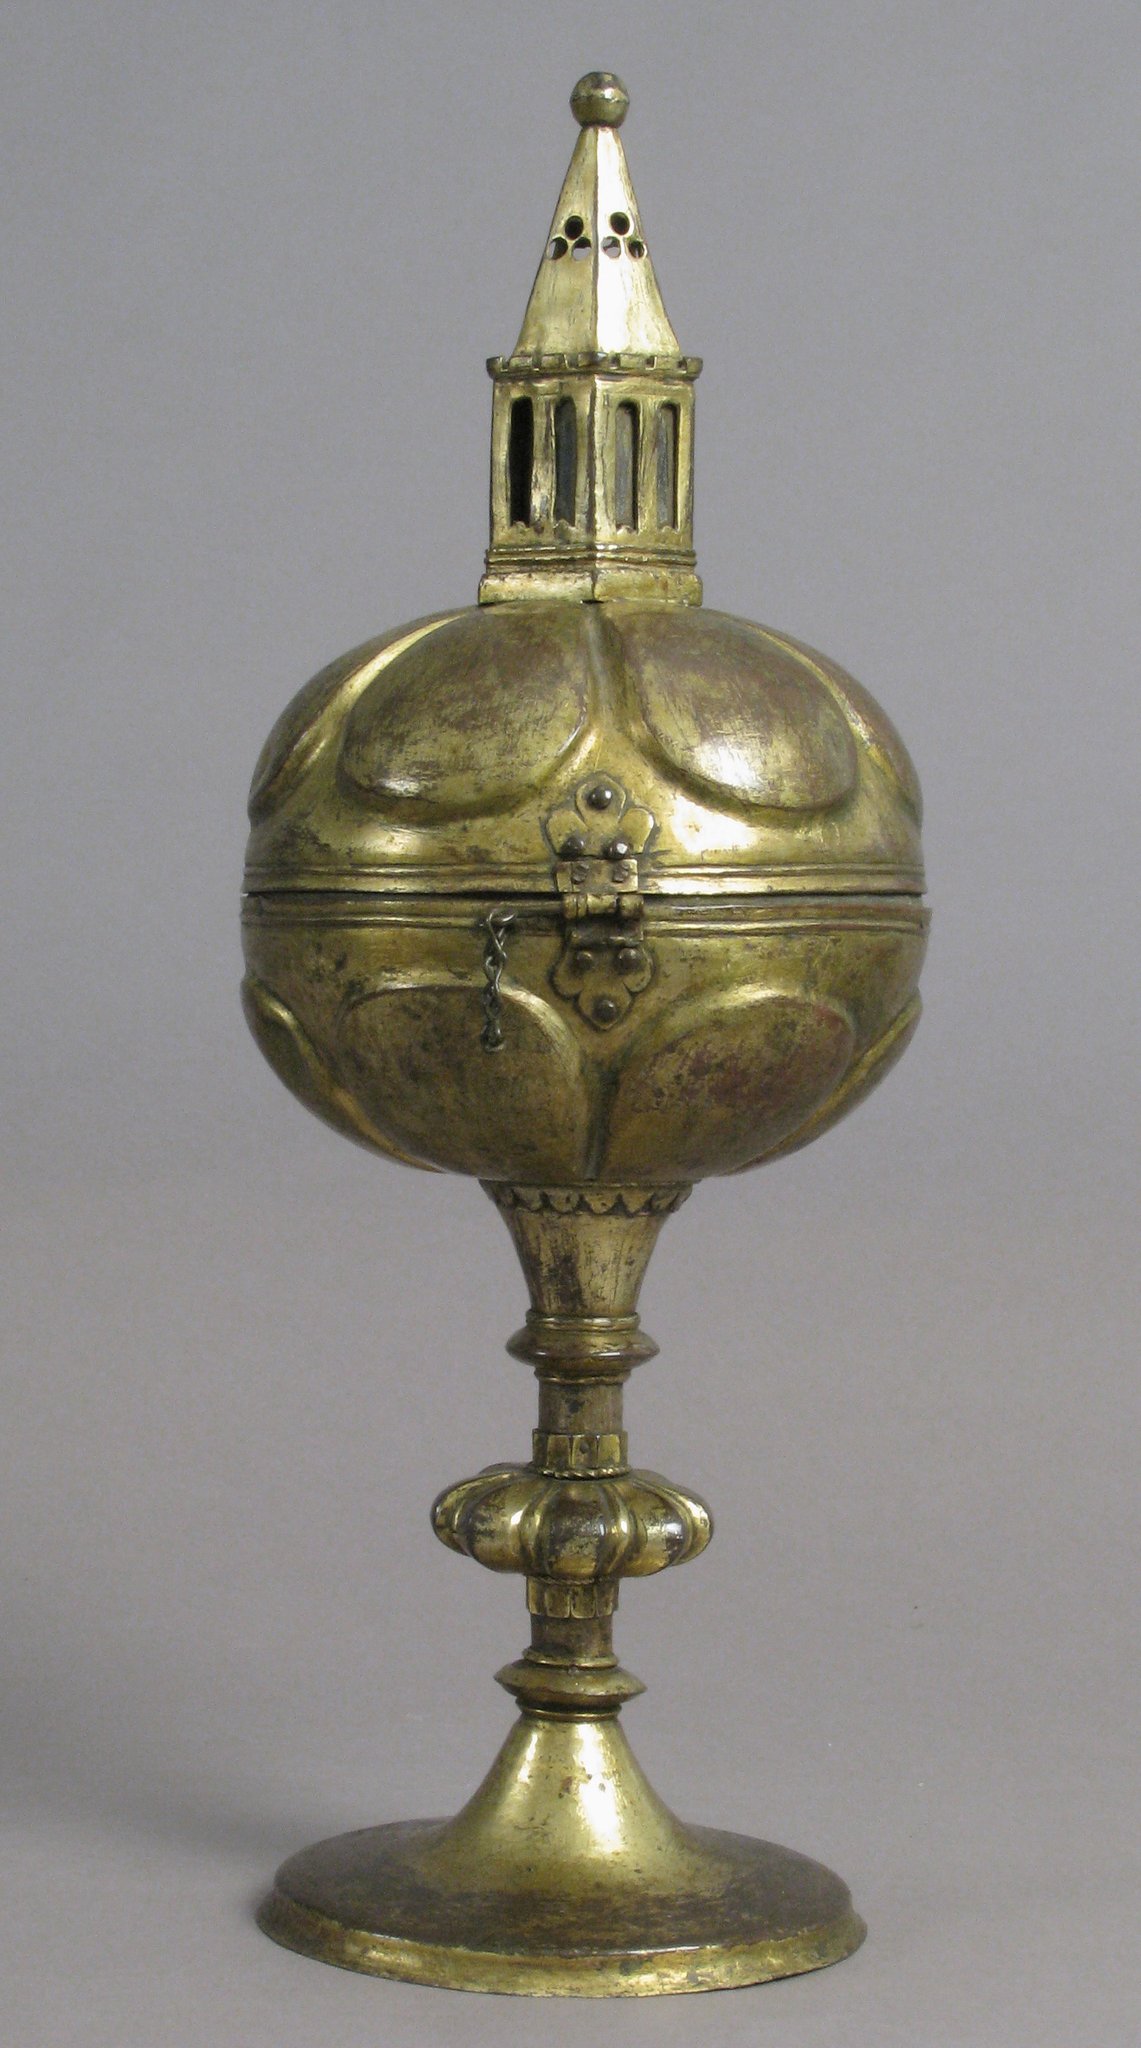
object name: ciborium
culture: german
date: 1367-1433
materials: gilt copper, glass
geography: germany